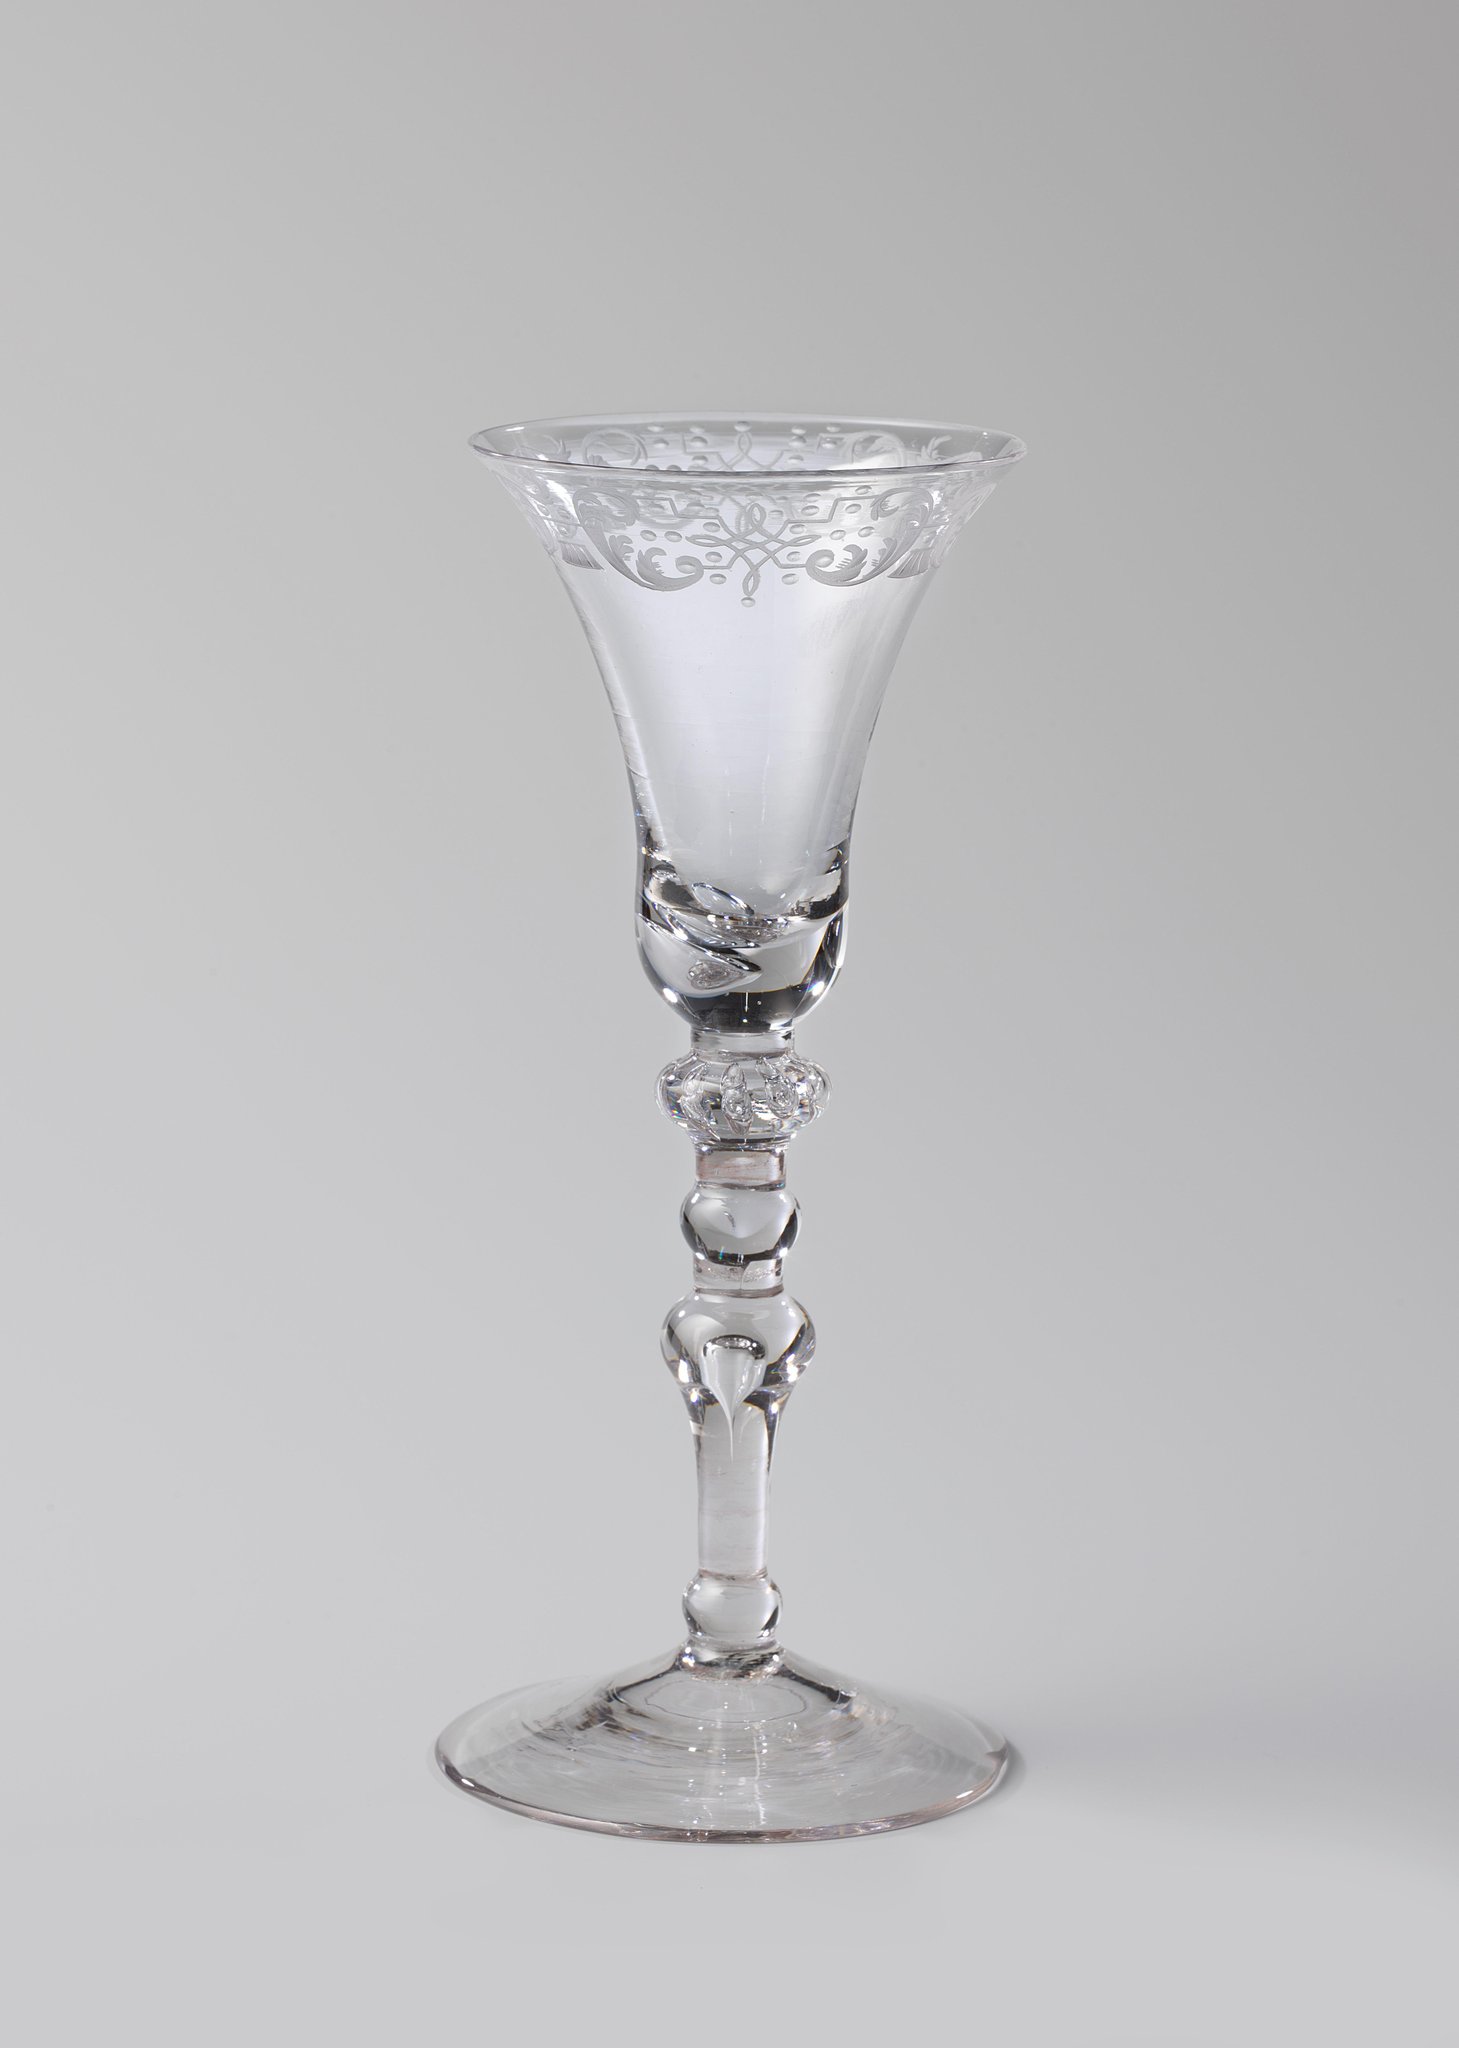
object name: goblet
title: Kelkglas met een ornamentrand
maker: Anonymous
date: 1750-1775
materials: glass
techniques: glassblowing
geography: northern netherlands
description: Kelkglas op balusterstam met drie knopen waarvan één met luchtblaasjes. De kelkrand is versierd met Lodewijk XV-ornament.